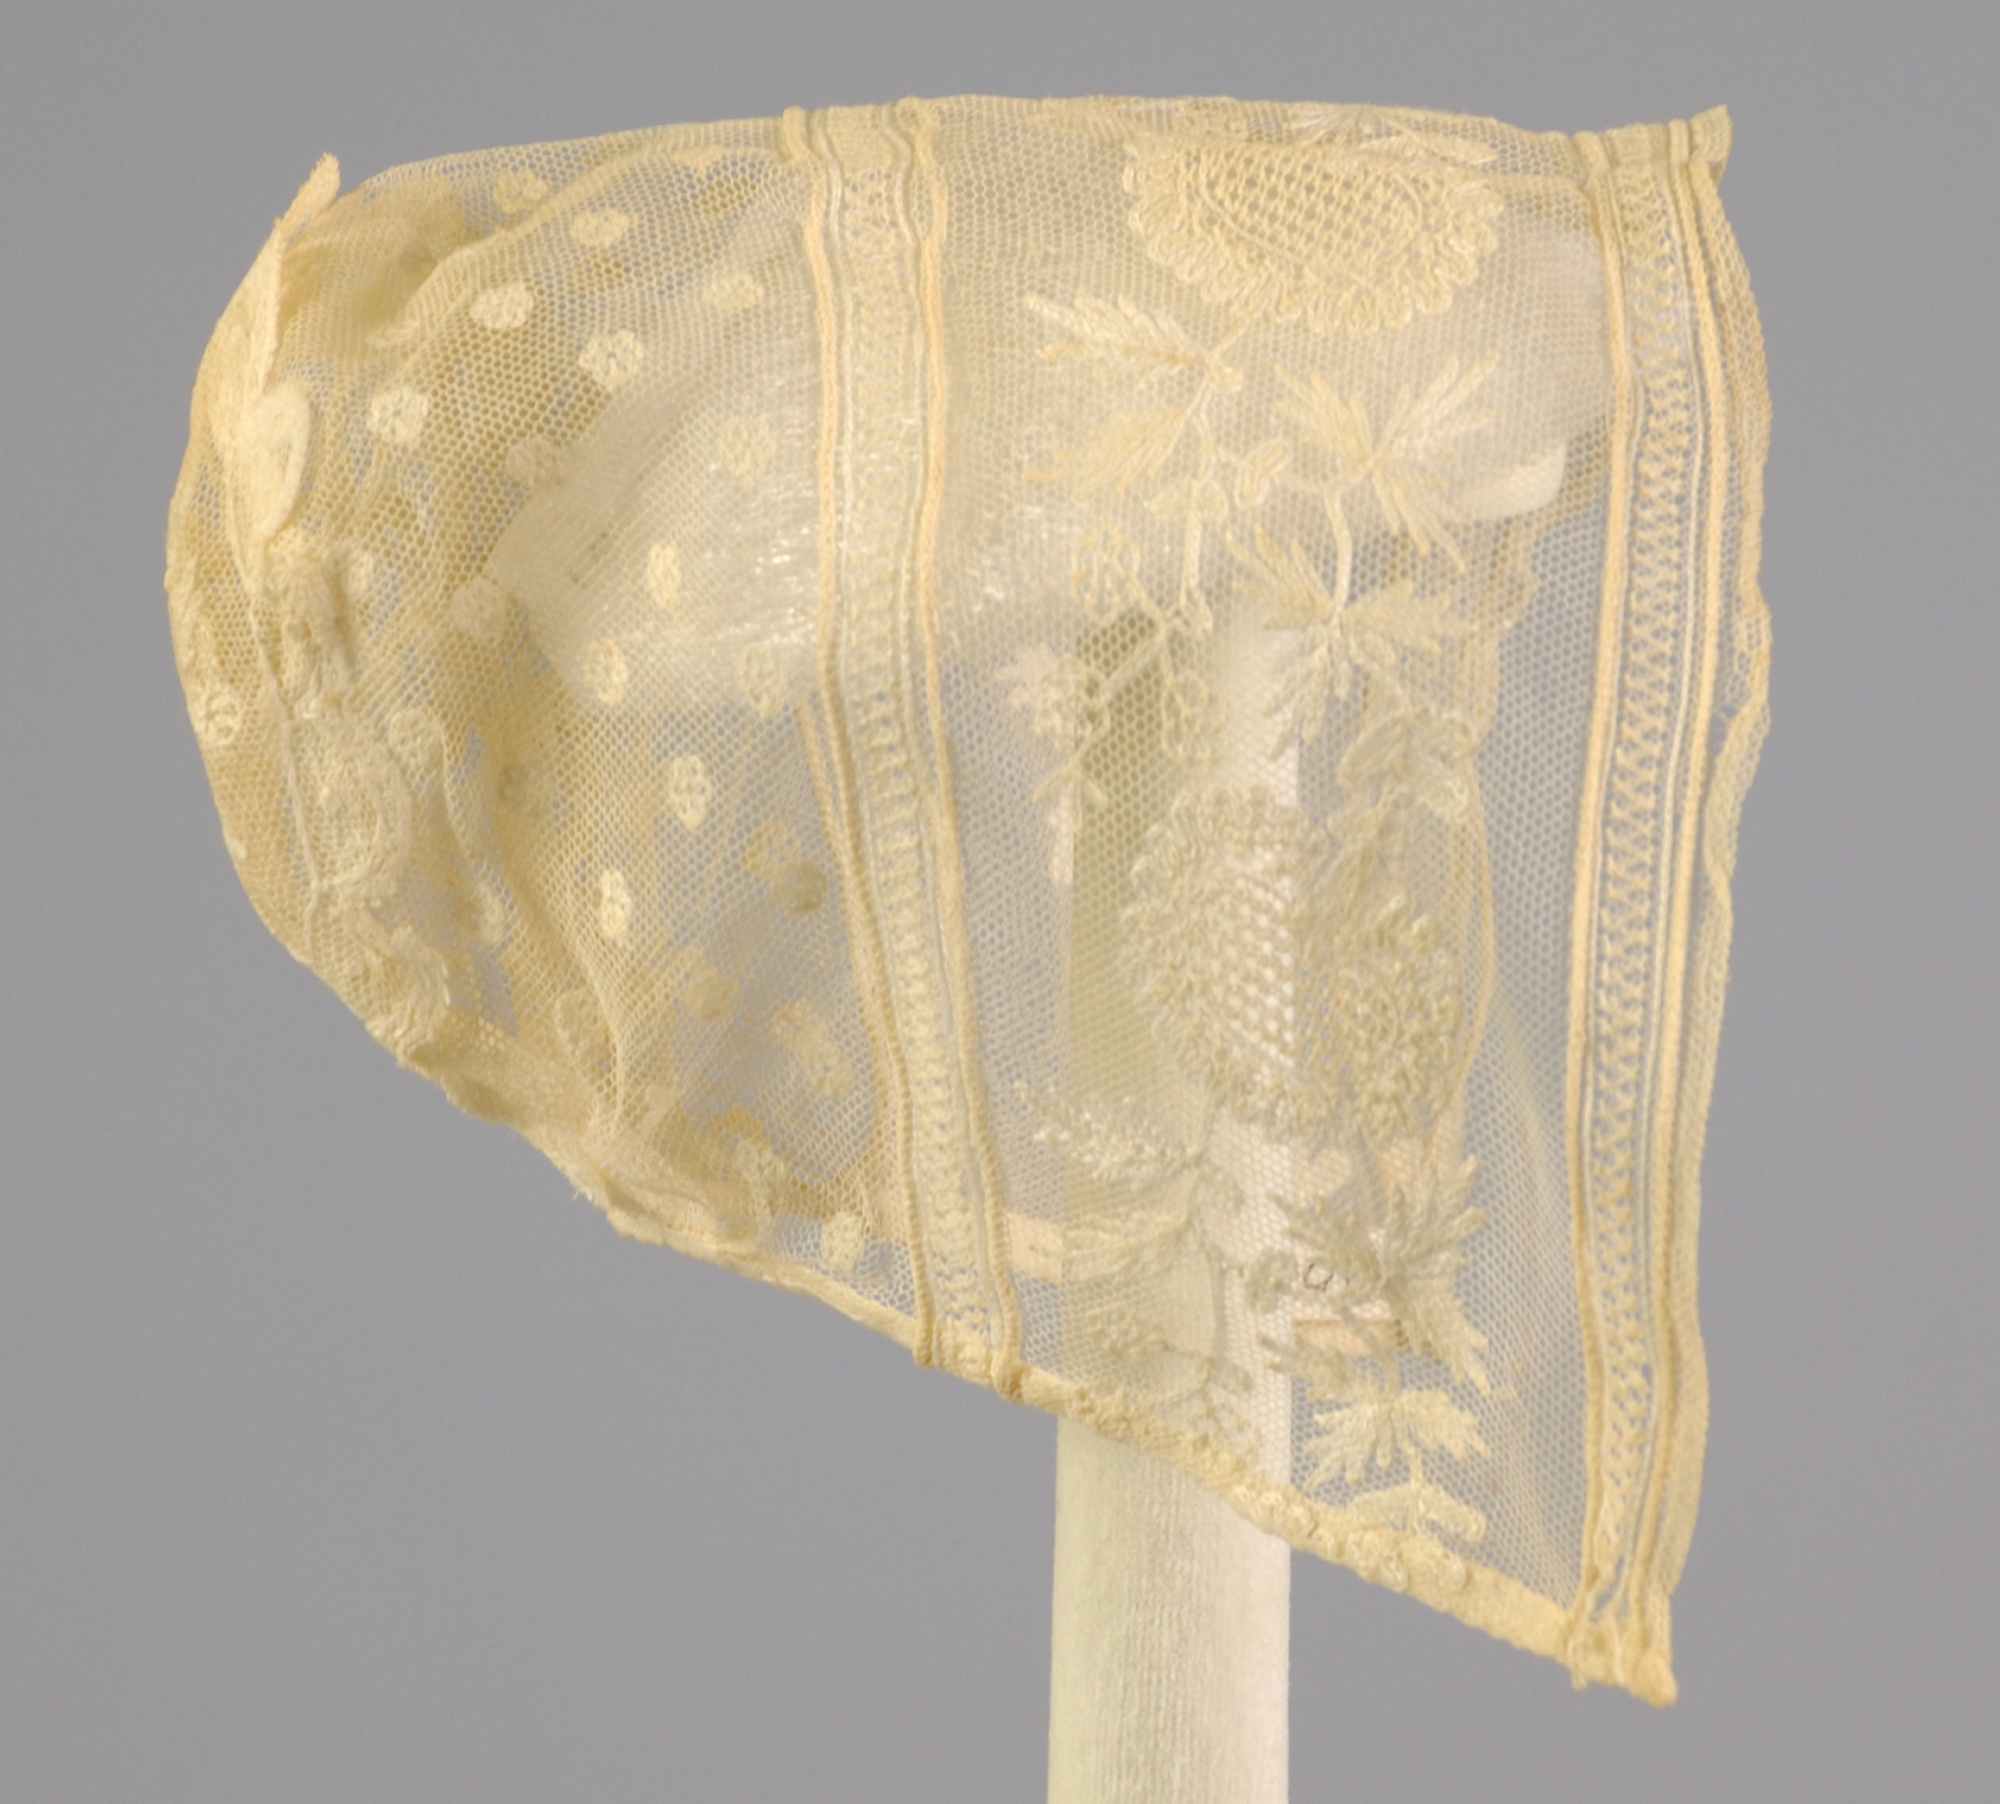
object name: bonnet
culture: irish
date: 1840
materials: linen